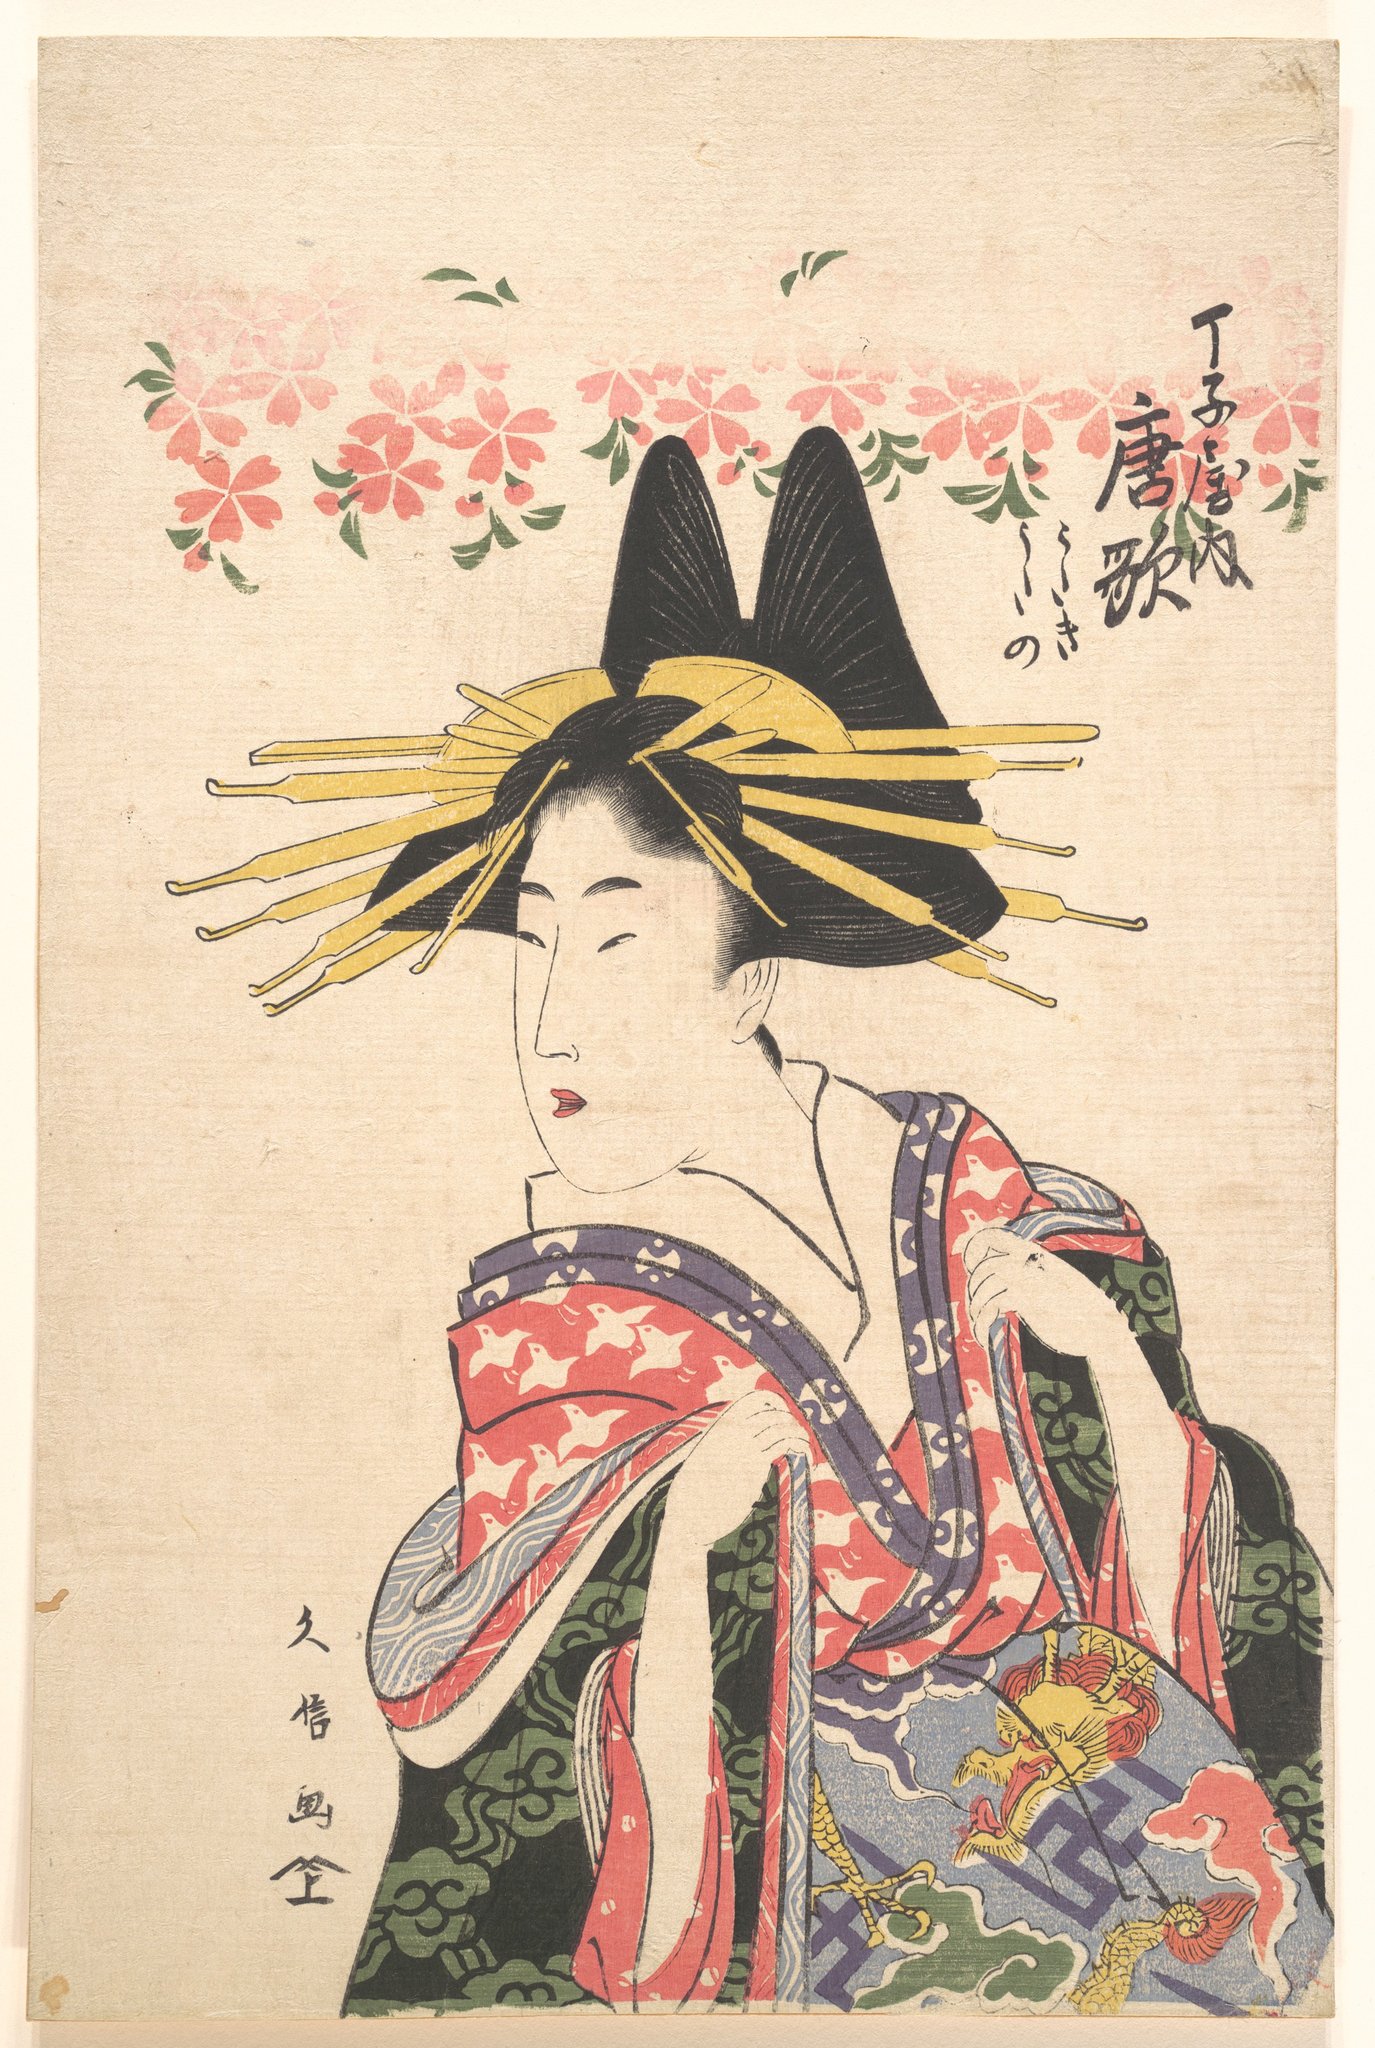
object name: print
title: A Parcel of Three Diverse Prints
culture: japanese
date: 1615-1868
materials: ink, paper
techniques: woodblock print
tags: women,flowers